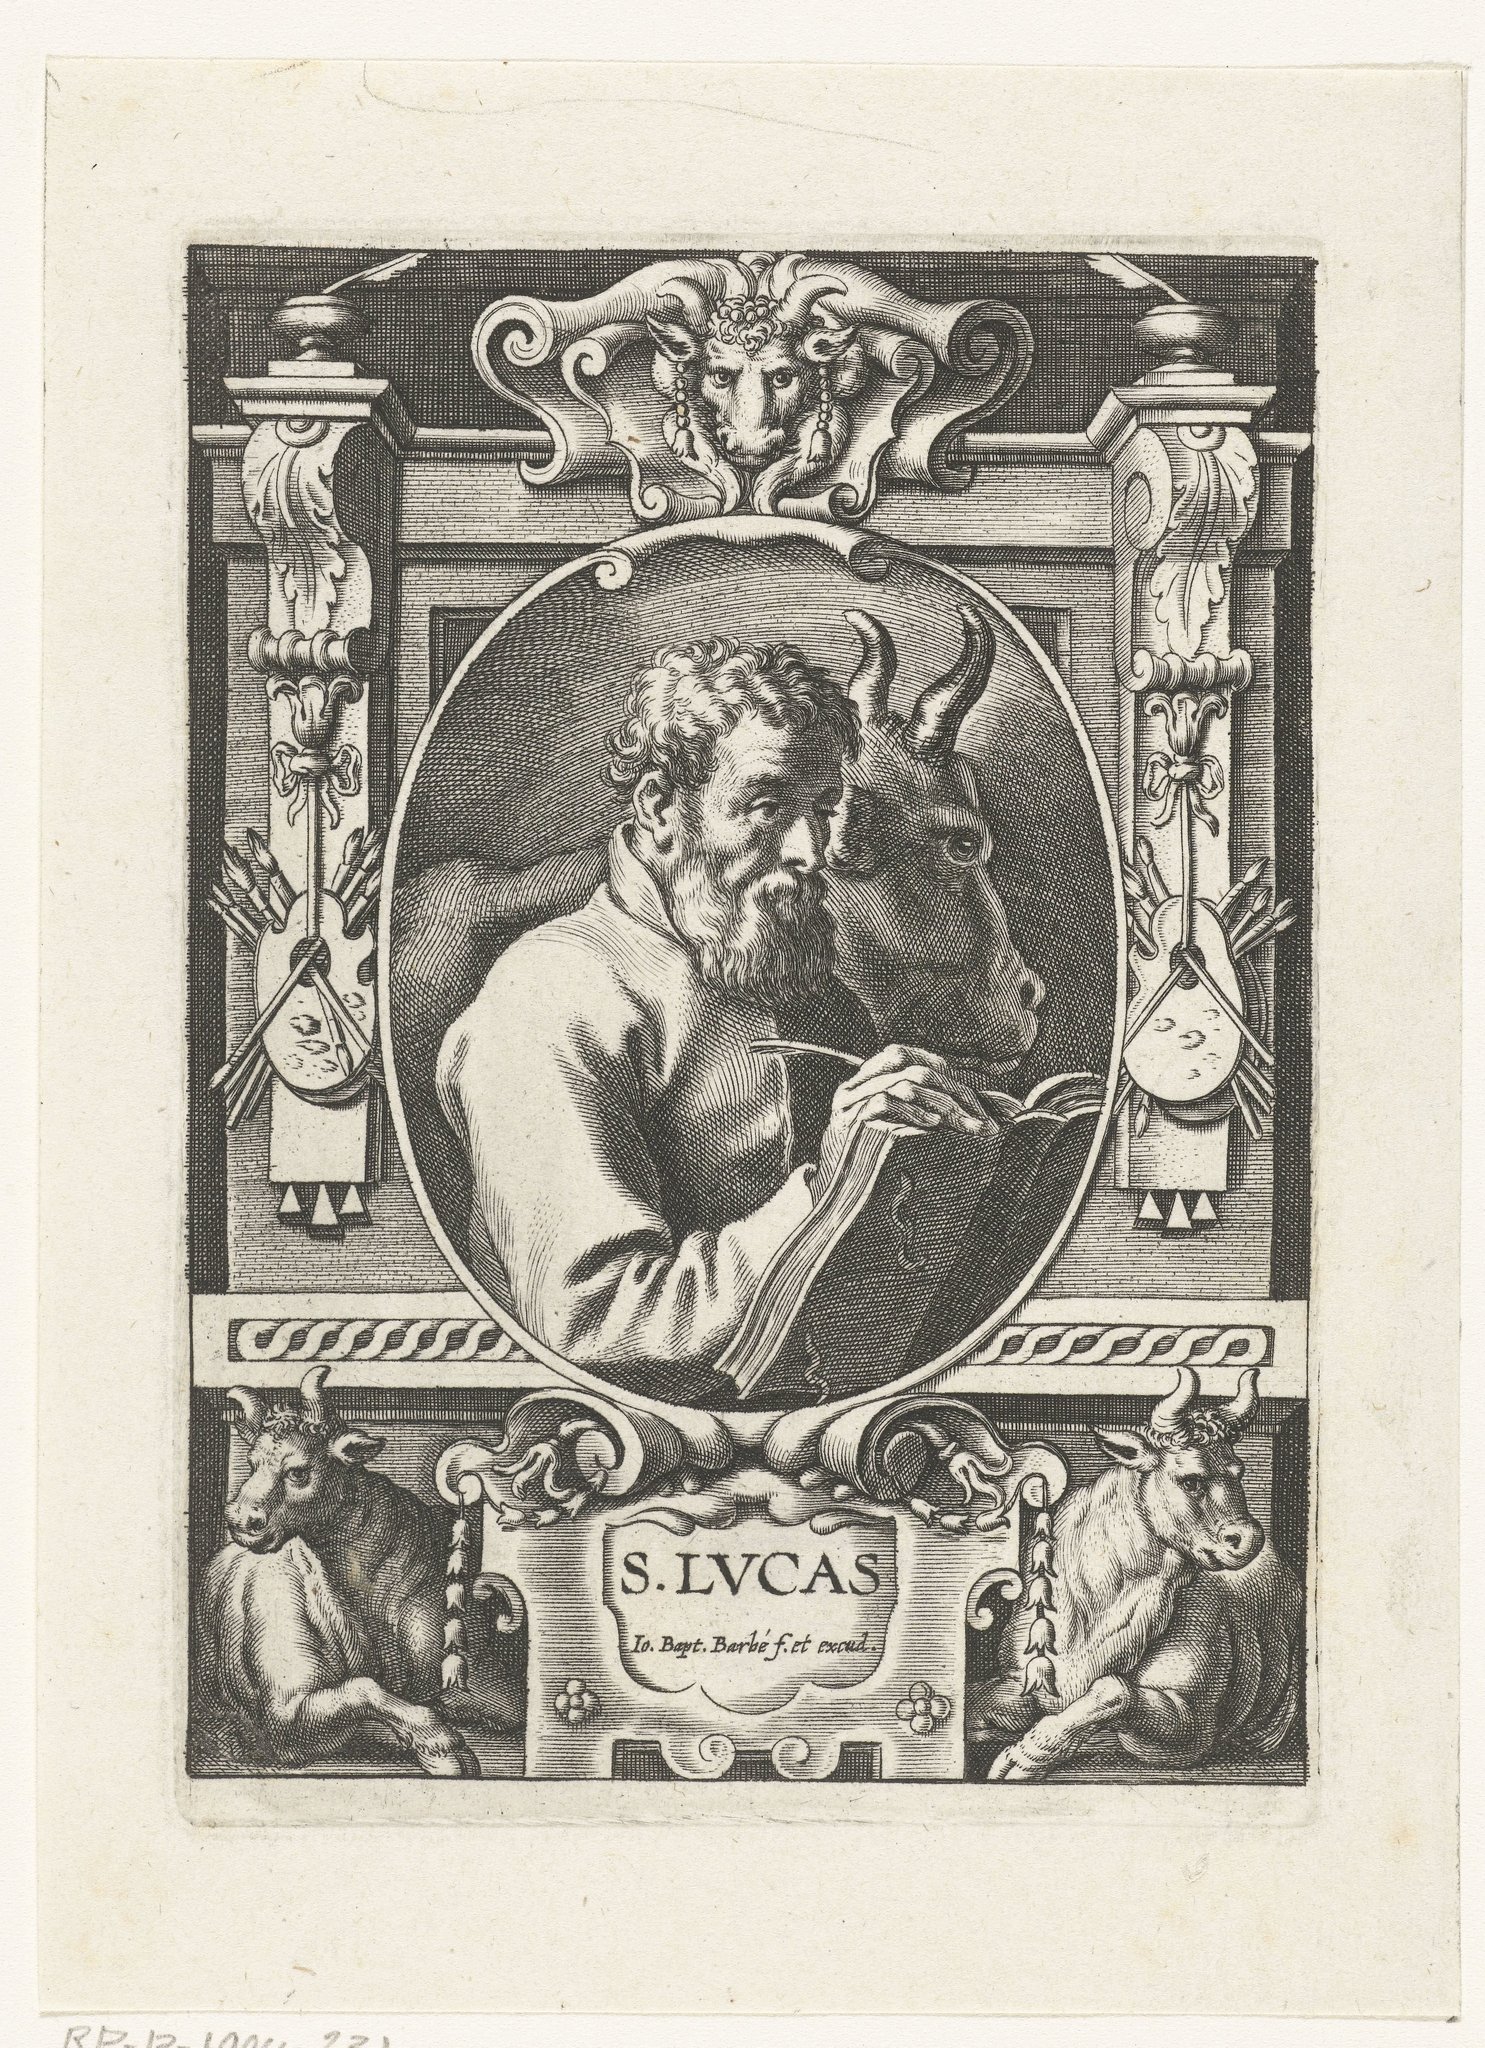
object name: print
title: S. Lvcas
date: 1588-1648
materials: paper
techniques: engraving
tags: luke the evangelist; possible attributes: book, (winged) ox, portrait of the virgin, surgical instruments, painter's utensils, scroll, ornament derived from architectural details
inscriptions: collector's mark: Lugt 2228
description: De evangelist Lucas, schrijvend, met zijn attribuut de os in een architecturale omlijsting waarin schilderspalet en penselen zijn verwerkt.